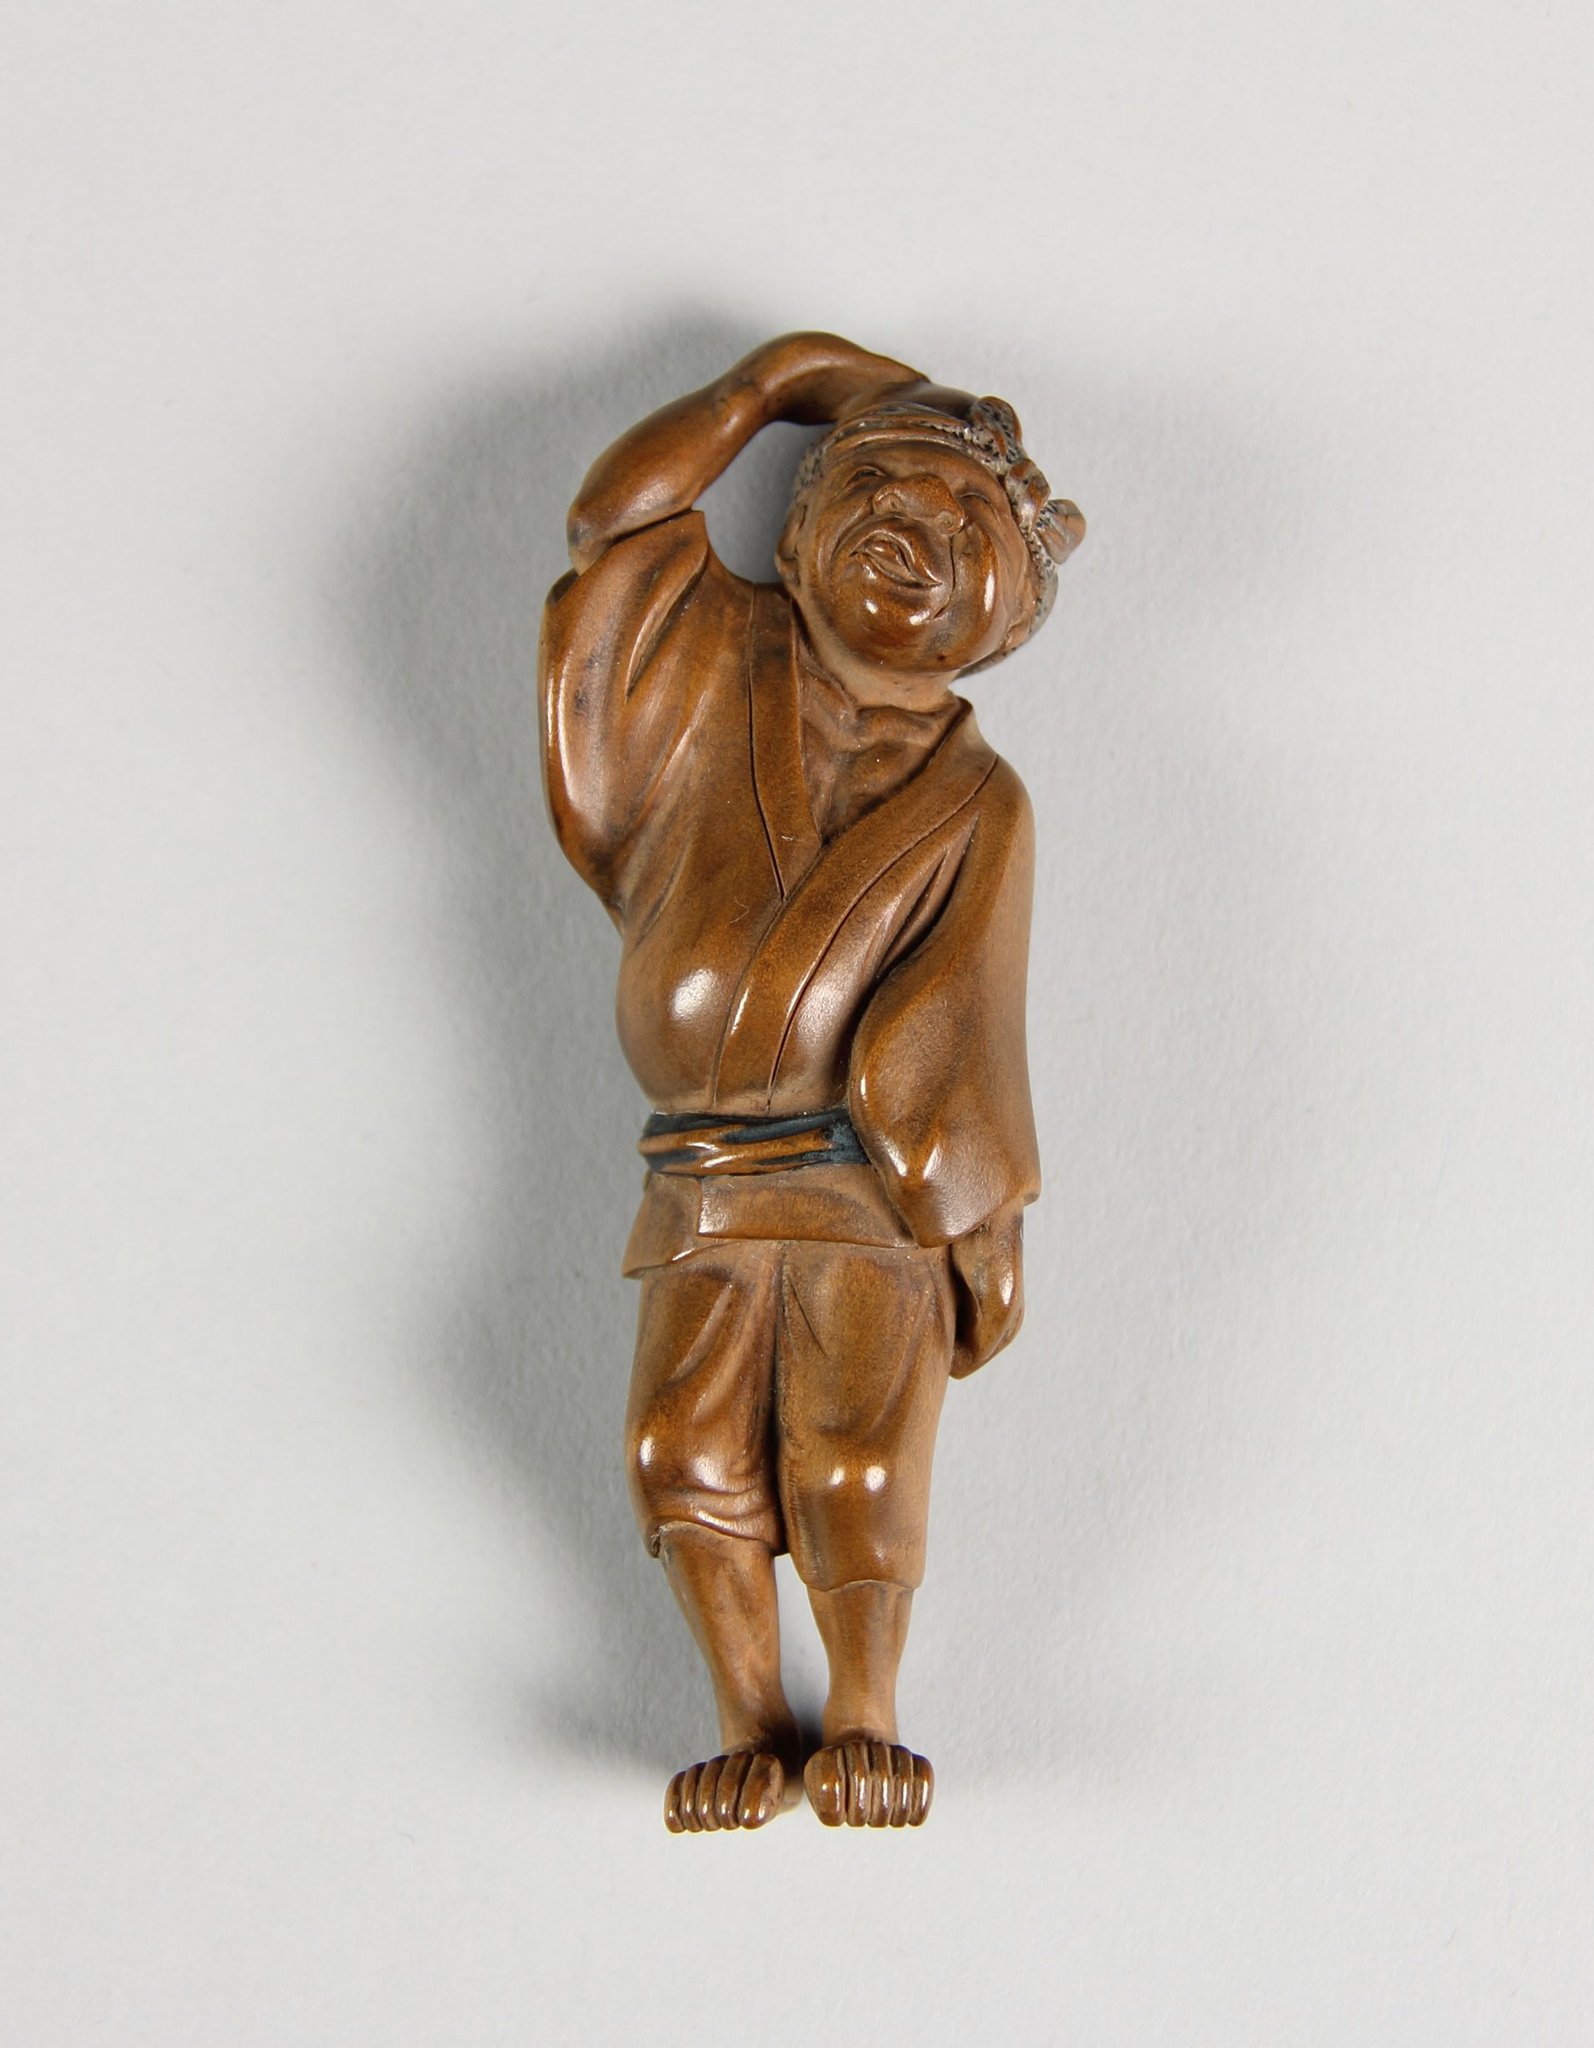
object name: netsuke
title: Netsuke of Drunken Man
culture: japanese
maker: sanshō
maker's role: artist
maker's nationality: japanese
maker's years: 1871-1936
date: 1867-1900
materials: wood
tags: drunkenness,men